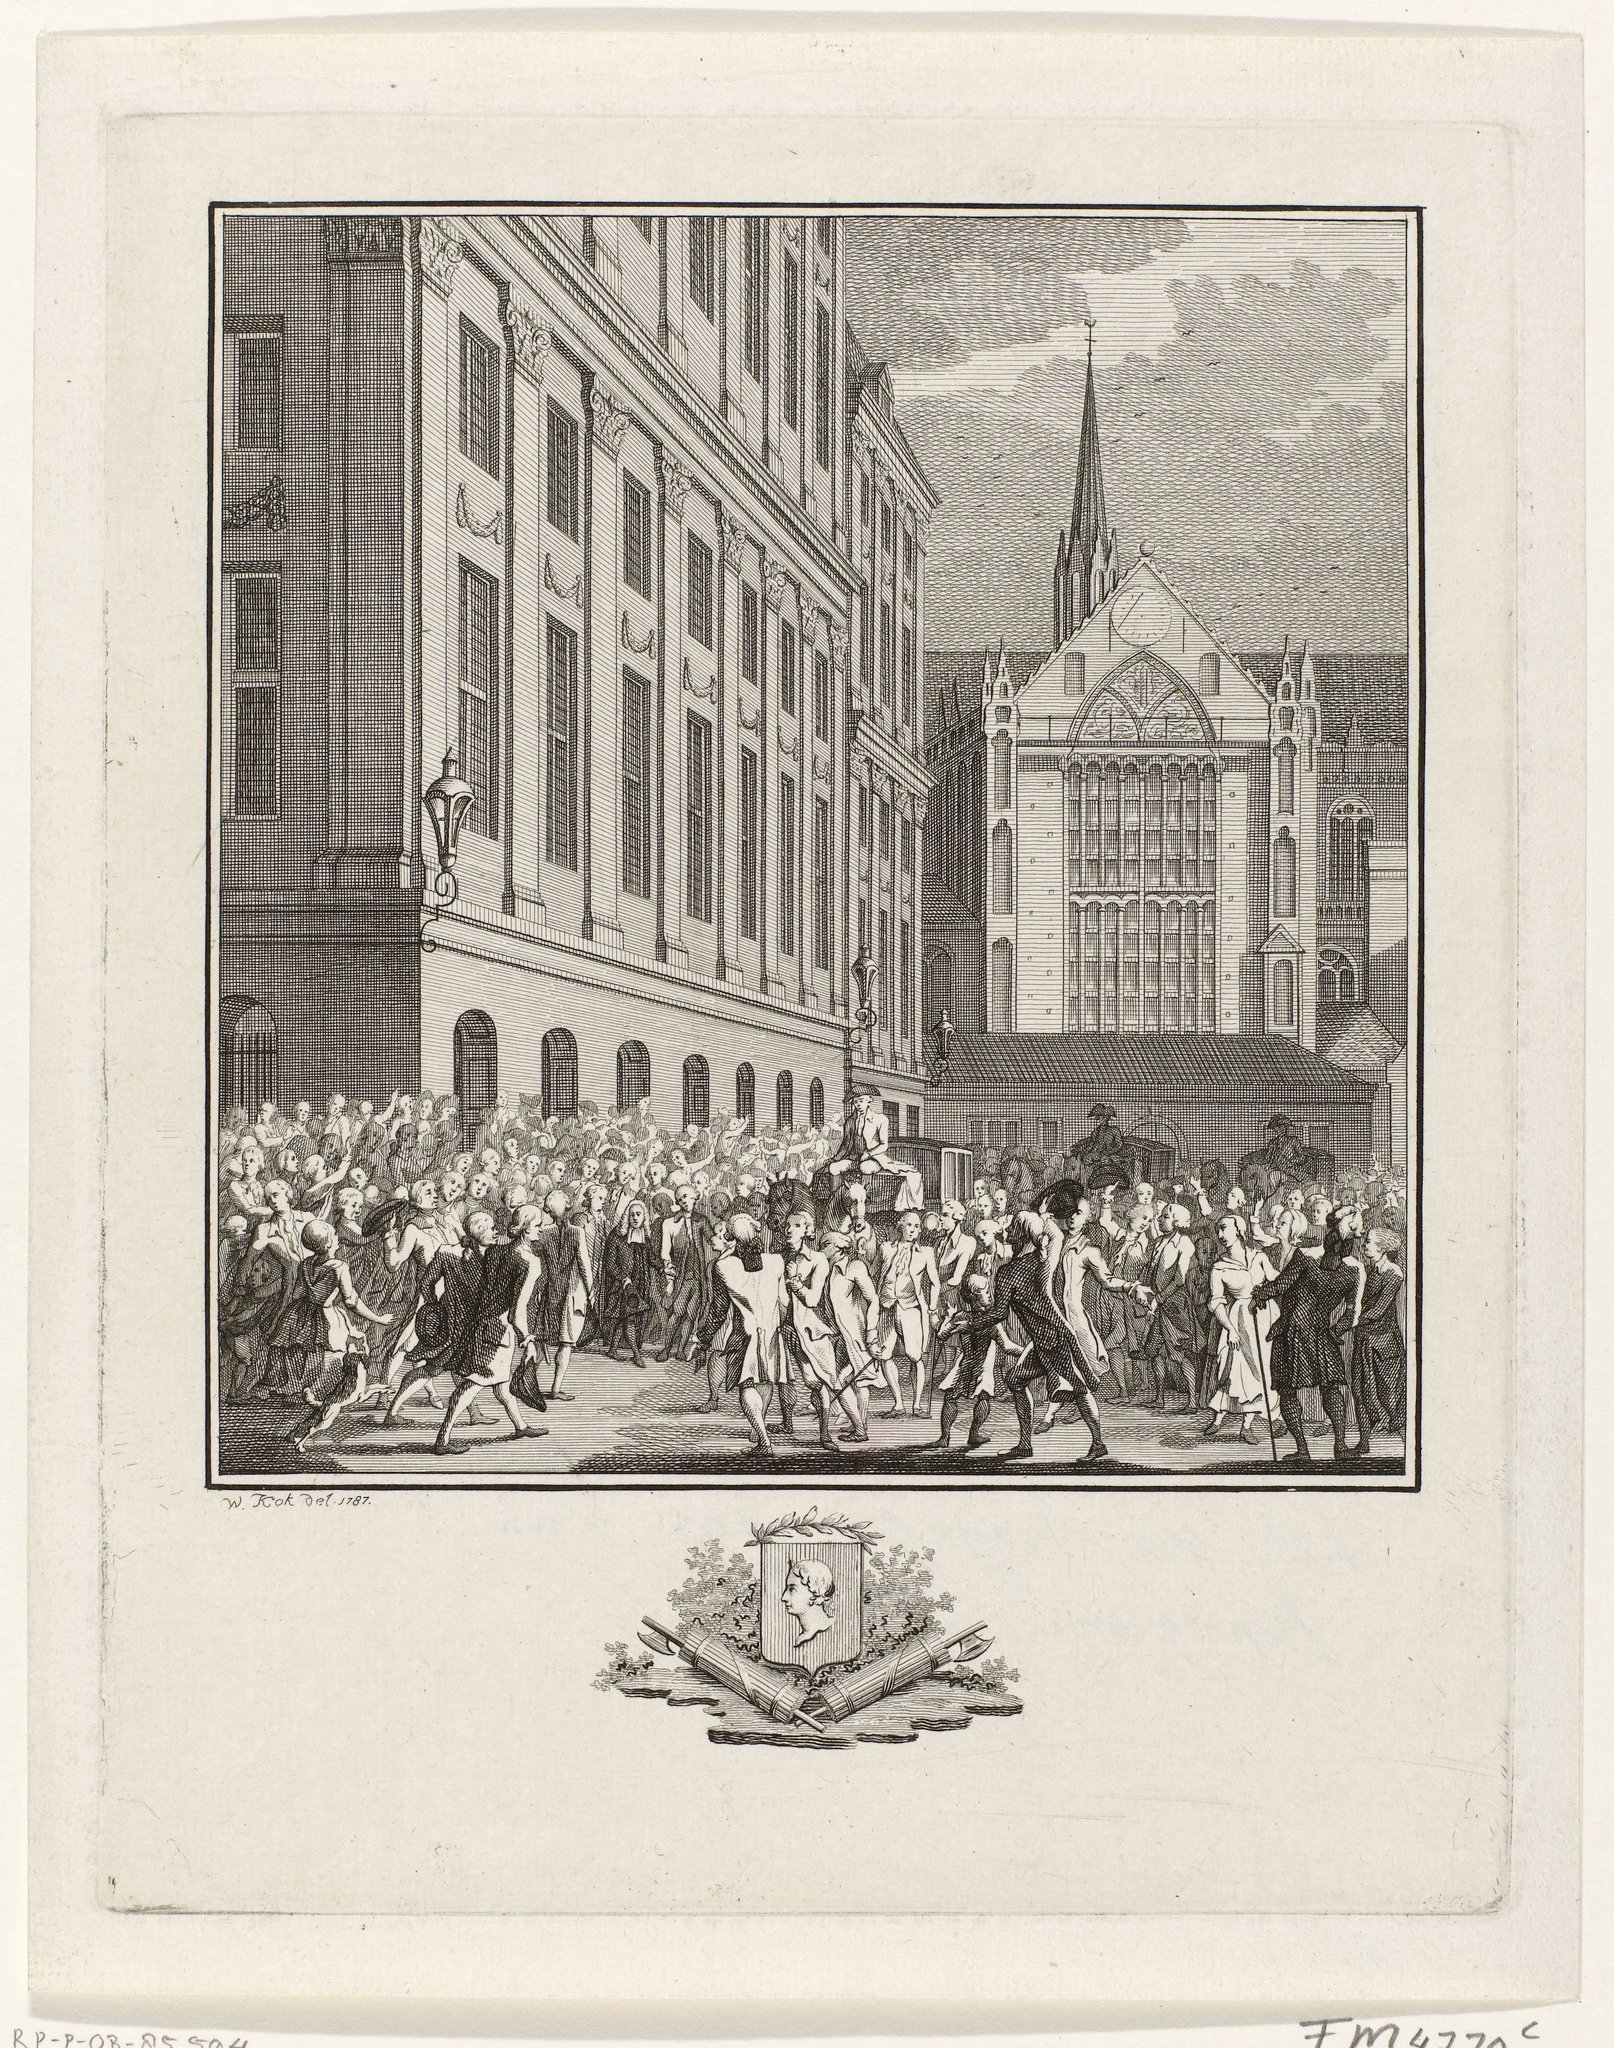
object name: print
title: Toejuiching van Hendrik Danielsz. Hooft op de Dam, 1787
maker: willem kok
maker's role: draughtsman, print maker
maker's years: 1761-1807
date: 1787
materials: paper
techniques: engraving, etching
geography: amsterdam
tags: mayor, hendrik danielsz. hooft, crowd, mob, mayor, burgomaster, triumphal entry and public reception, pageant, 'entrée solennelle', 'joyeuse entrée', patriots (1780-1795)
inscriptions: collector's mark: Lugt 2228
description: De Amsterdamse burgemeester Hendrik Danielsz. Hooft wordt bij vertrek in zijn rijtuig toegejuicht door het publiek op de Dam, 26 februari 1787. In de marge het wapen van Hooft.